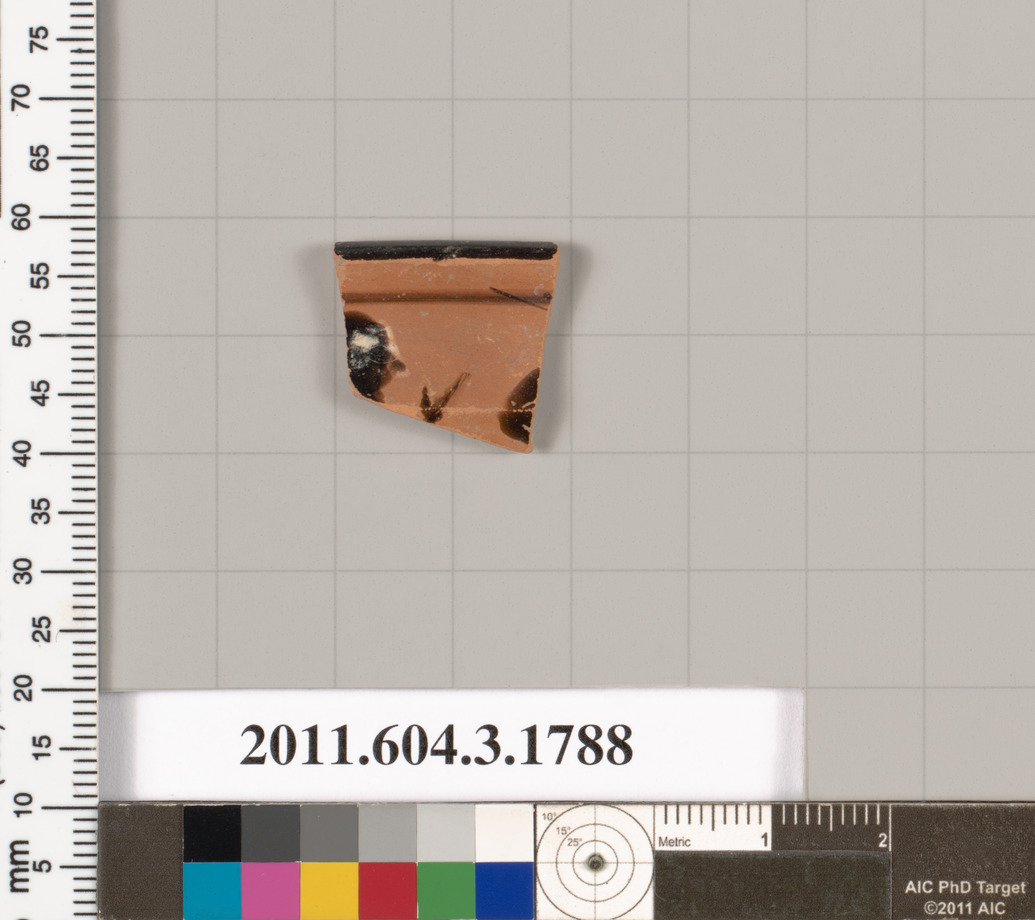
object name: kylix fragment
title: Terracotta rim fragment of a kylix: Lip cup (drinking cup)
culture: greek, attic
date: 550-526 BCE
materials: terracotta